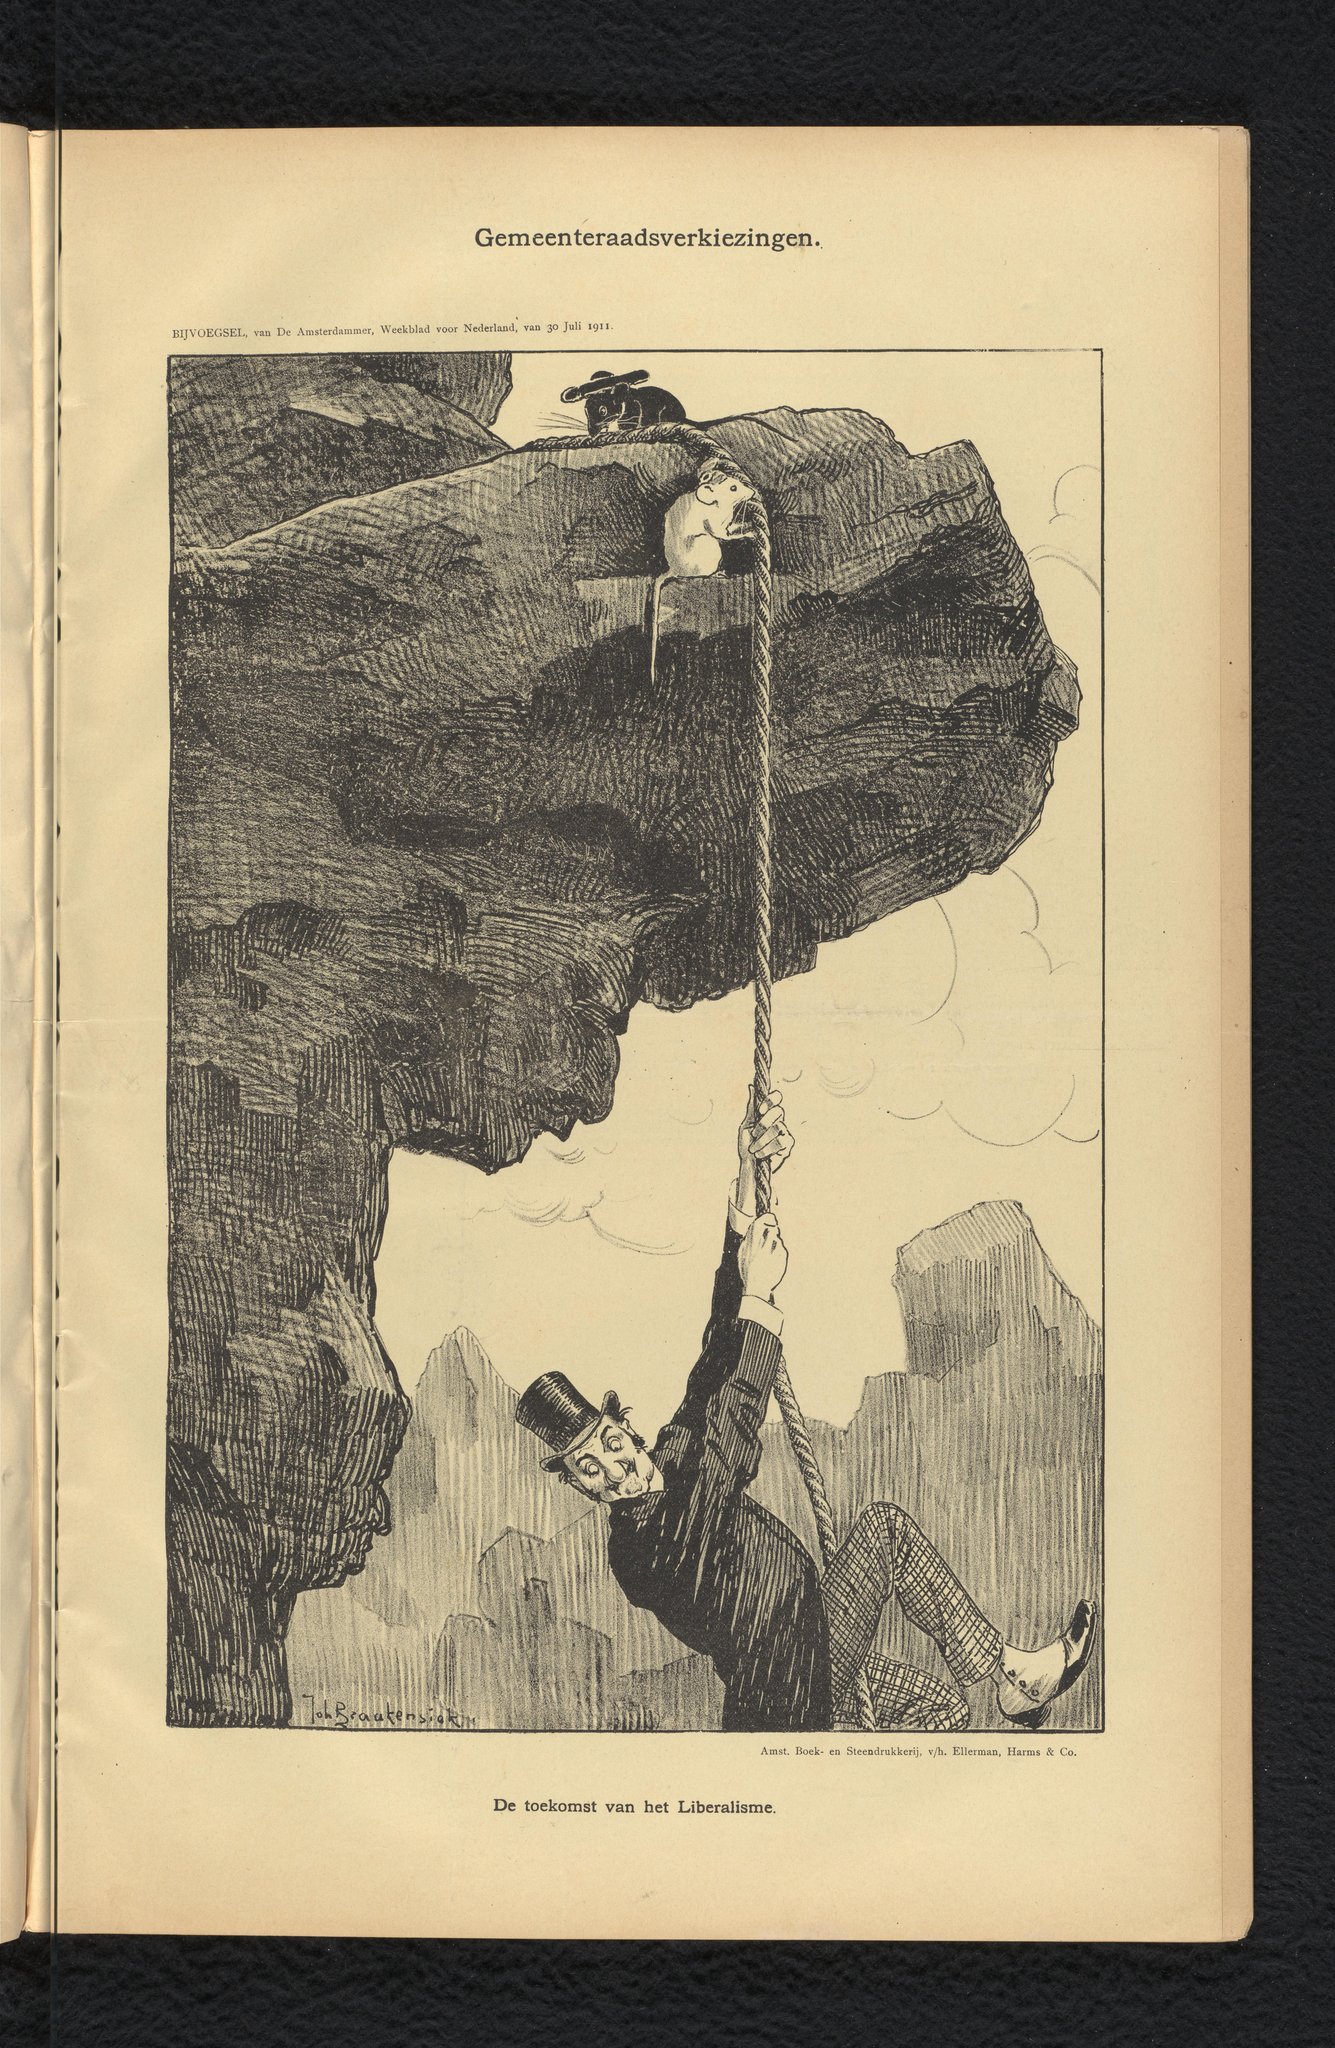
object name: cartoon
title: Gemeenteraadsverkiezingen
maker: johan braakensiek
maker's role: draughtsman, print maker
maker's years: 1858-1940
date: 1911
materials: paper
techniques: lithograph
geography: netherlands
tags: voting, election, ravine, chasm, abyss, canyon, political parties, political caricatures and satires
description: Een man, 'het Liberalisme', hangt aan een koord boven het ravijn. Twee ratten knagen aan het koord.